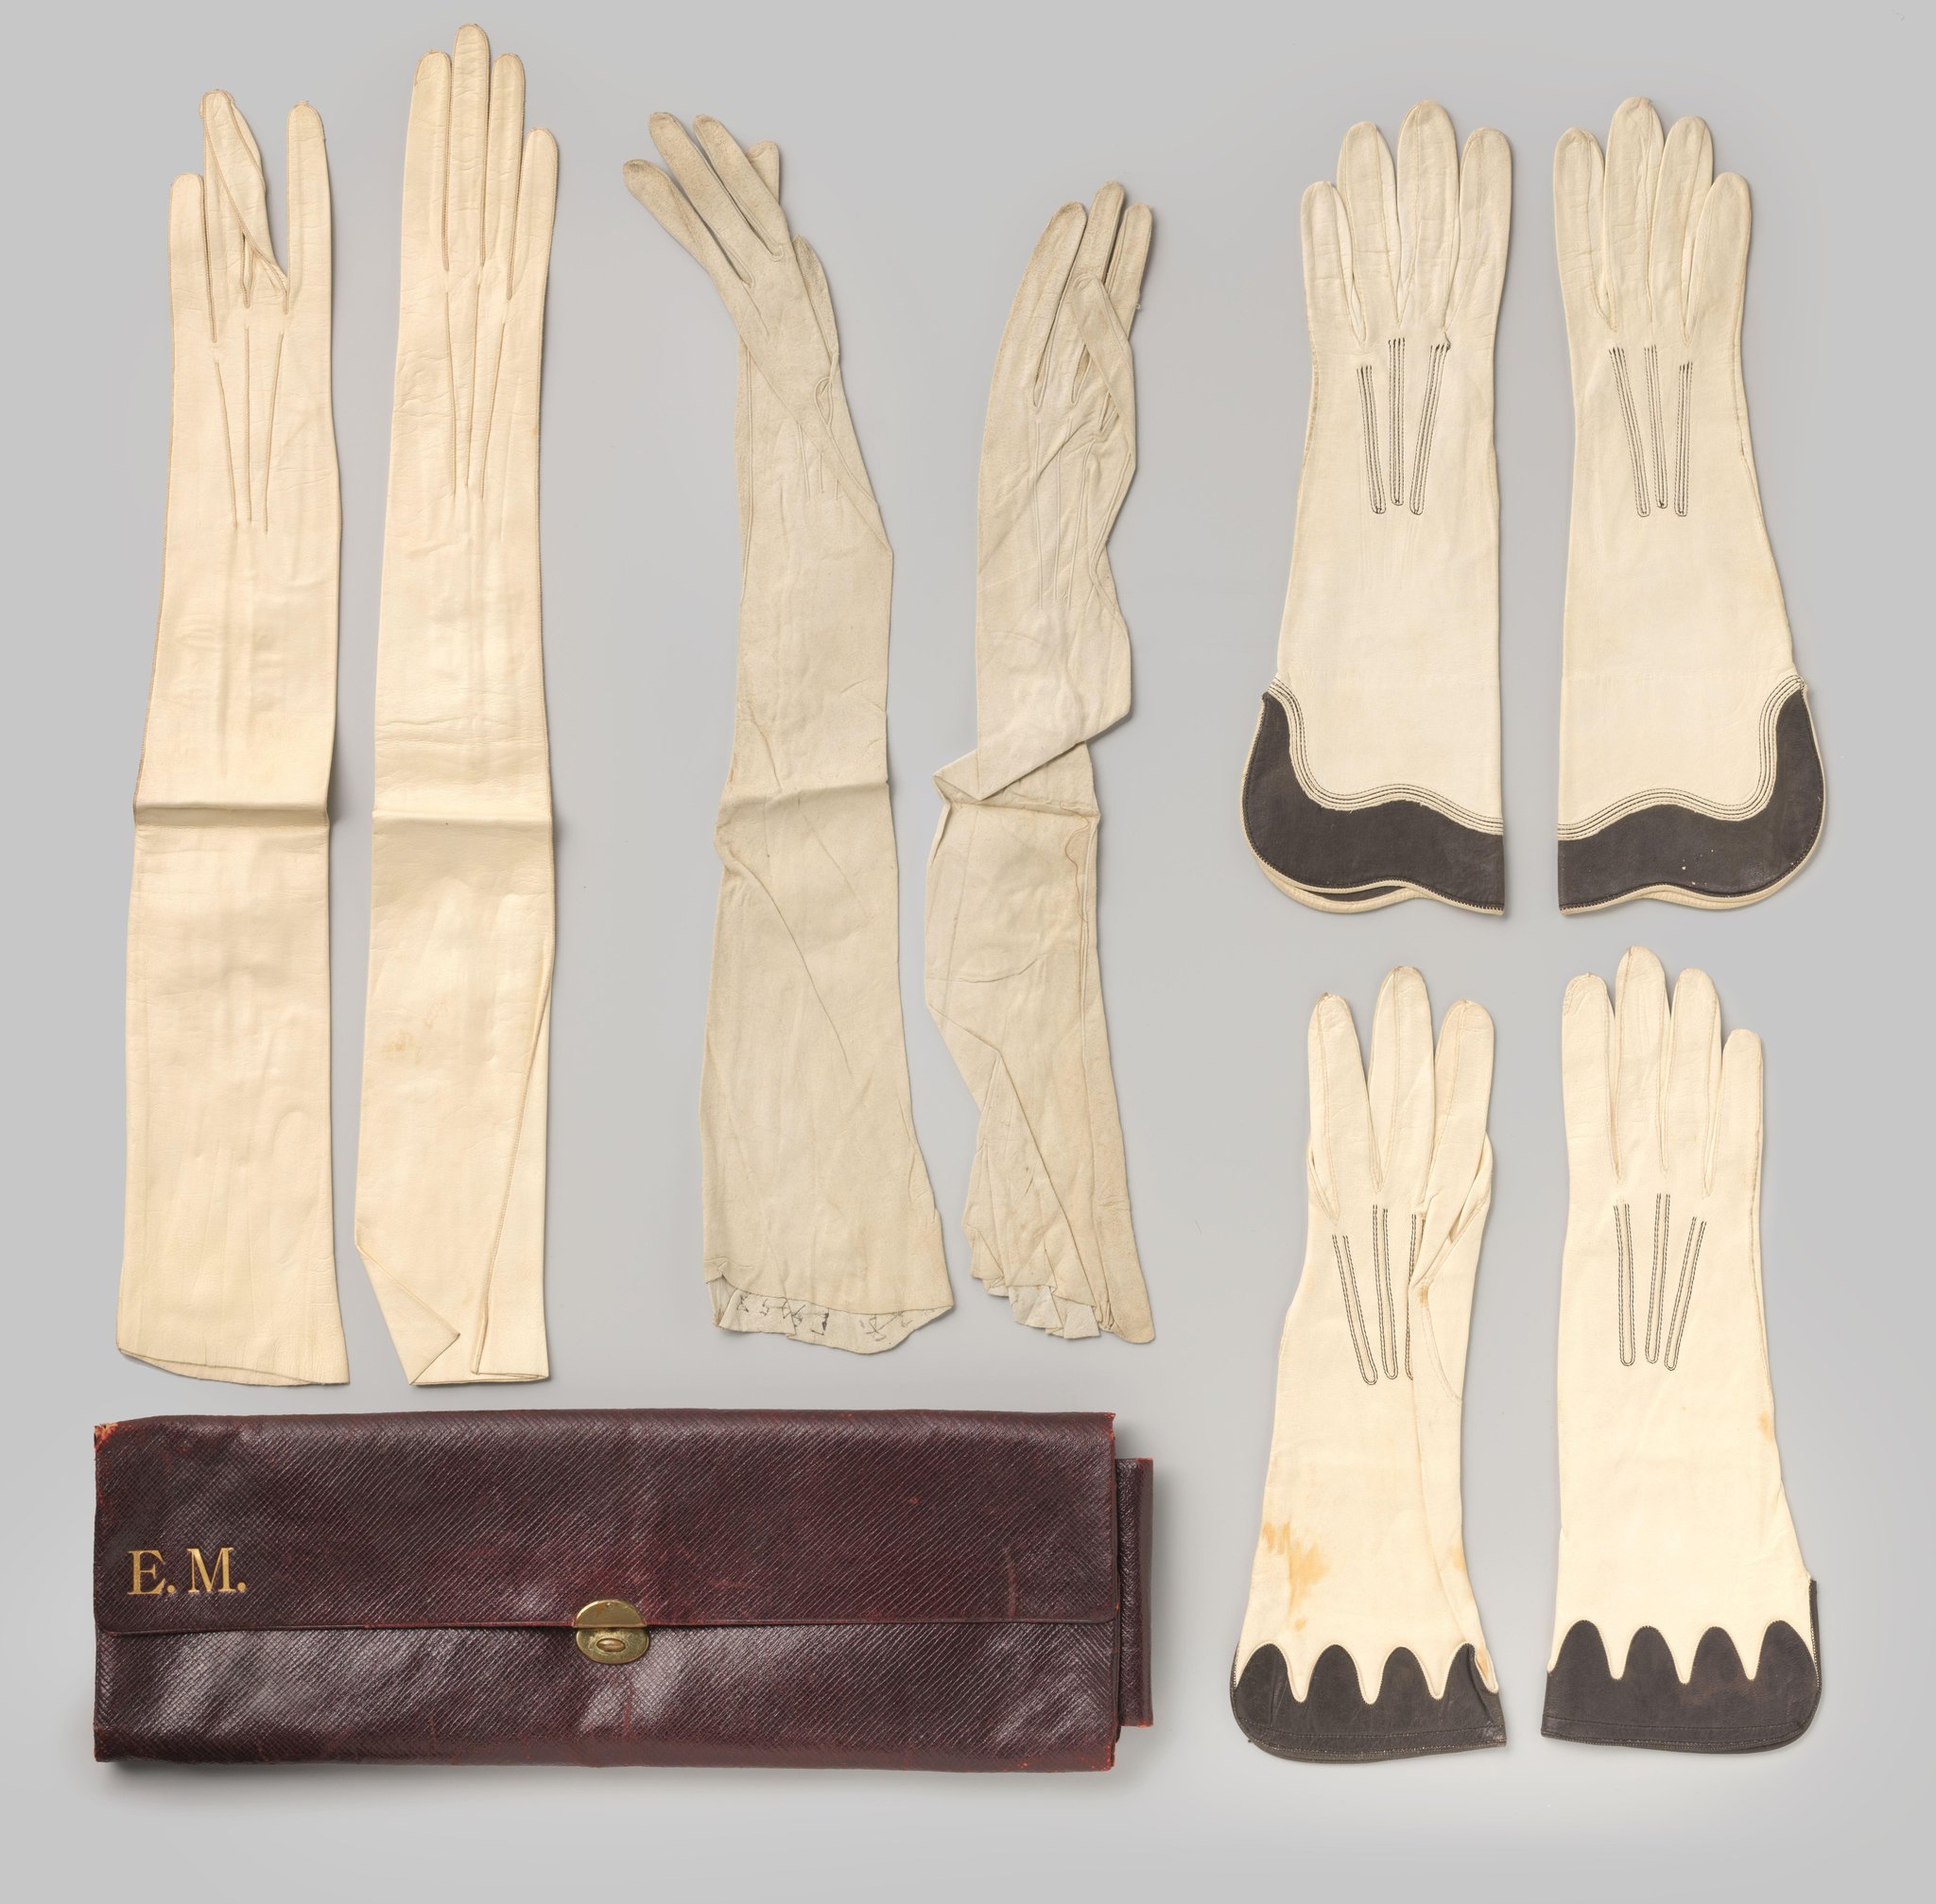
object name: glove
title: Vier paar witte leren handschoenen in etui van leer met daarop de initialen E.M.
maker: Anonymous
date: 1900-1925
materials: leather, metal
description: Dit object is onderdeel van de nalatenschap van Isabel Elon-Wachenheimer (1928-2010). Tot haar overlijden behoorde het samen met de andere objecten uit de nalatenschap tot haar privédomein van Isabel Wachenheimer. In die particuliere context zijn deze objecten tezamen en individueel aandenkens - aan de jeugd, ouders en familie van Isabel Wachenheimer vóór en tijdens de Shoah en aan haar leven na de Tweede Wereldoorlog. Isabel Wachenheimer, die van juni 1943 tot mei 1945 gevangen zat in Kamp Westerbork, Theresienstadt, Auschwitz, Lenzing a/d Oberdonau (een buitenkamp van Mauthausen), overleefde de Shoah. Haar ouders – Eugène Wachenheimer en Else Wachenheimer-Moos - werden op 14 oktober 1944 in Auschwitz-Birkenau vermoord.